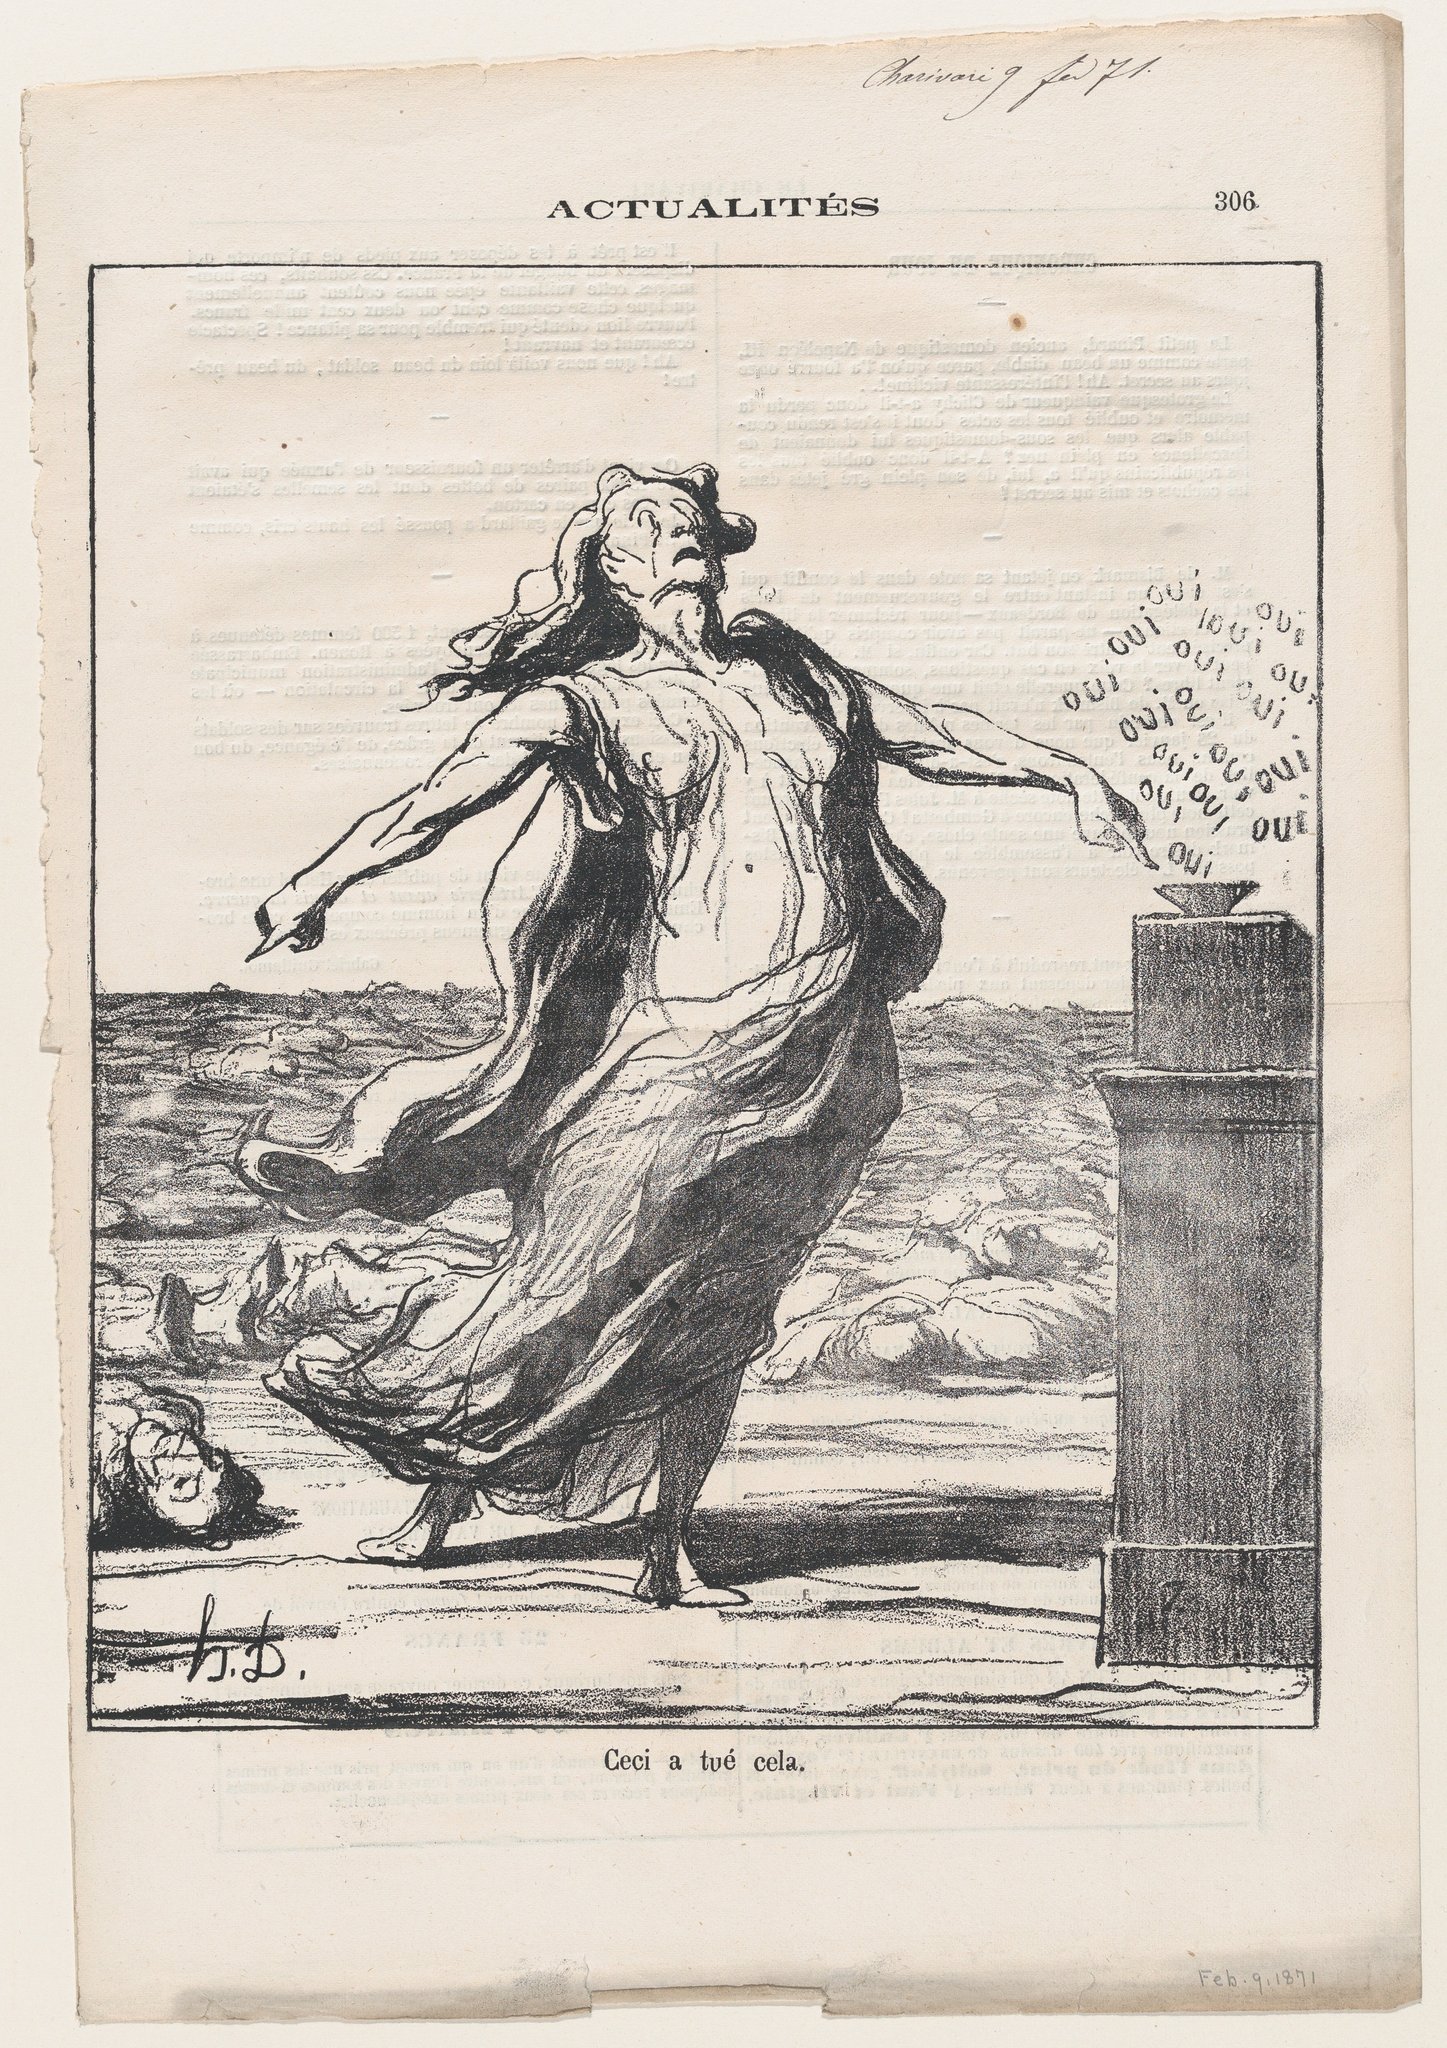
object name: print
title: These are responsible for those, from 'News of the day,' published in Le Charivari, February 9, 1871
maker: honoré daumier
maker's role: artist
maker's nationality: french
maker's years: 1808-1879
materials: paper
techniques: lithograph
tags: female nudes